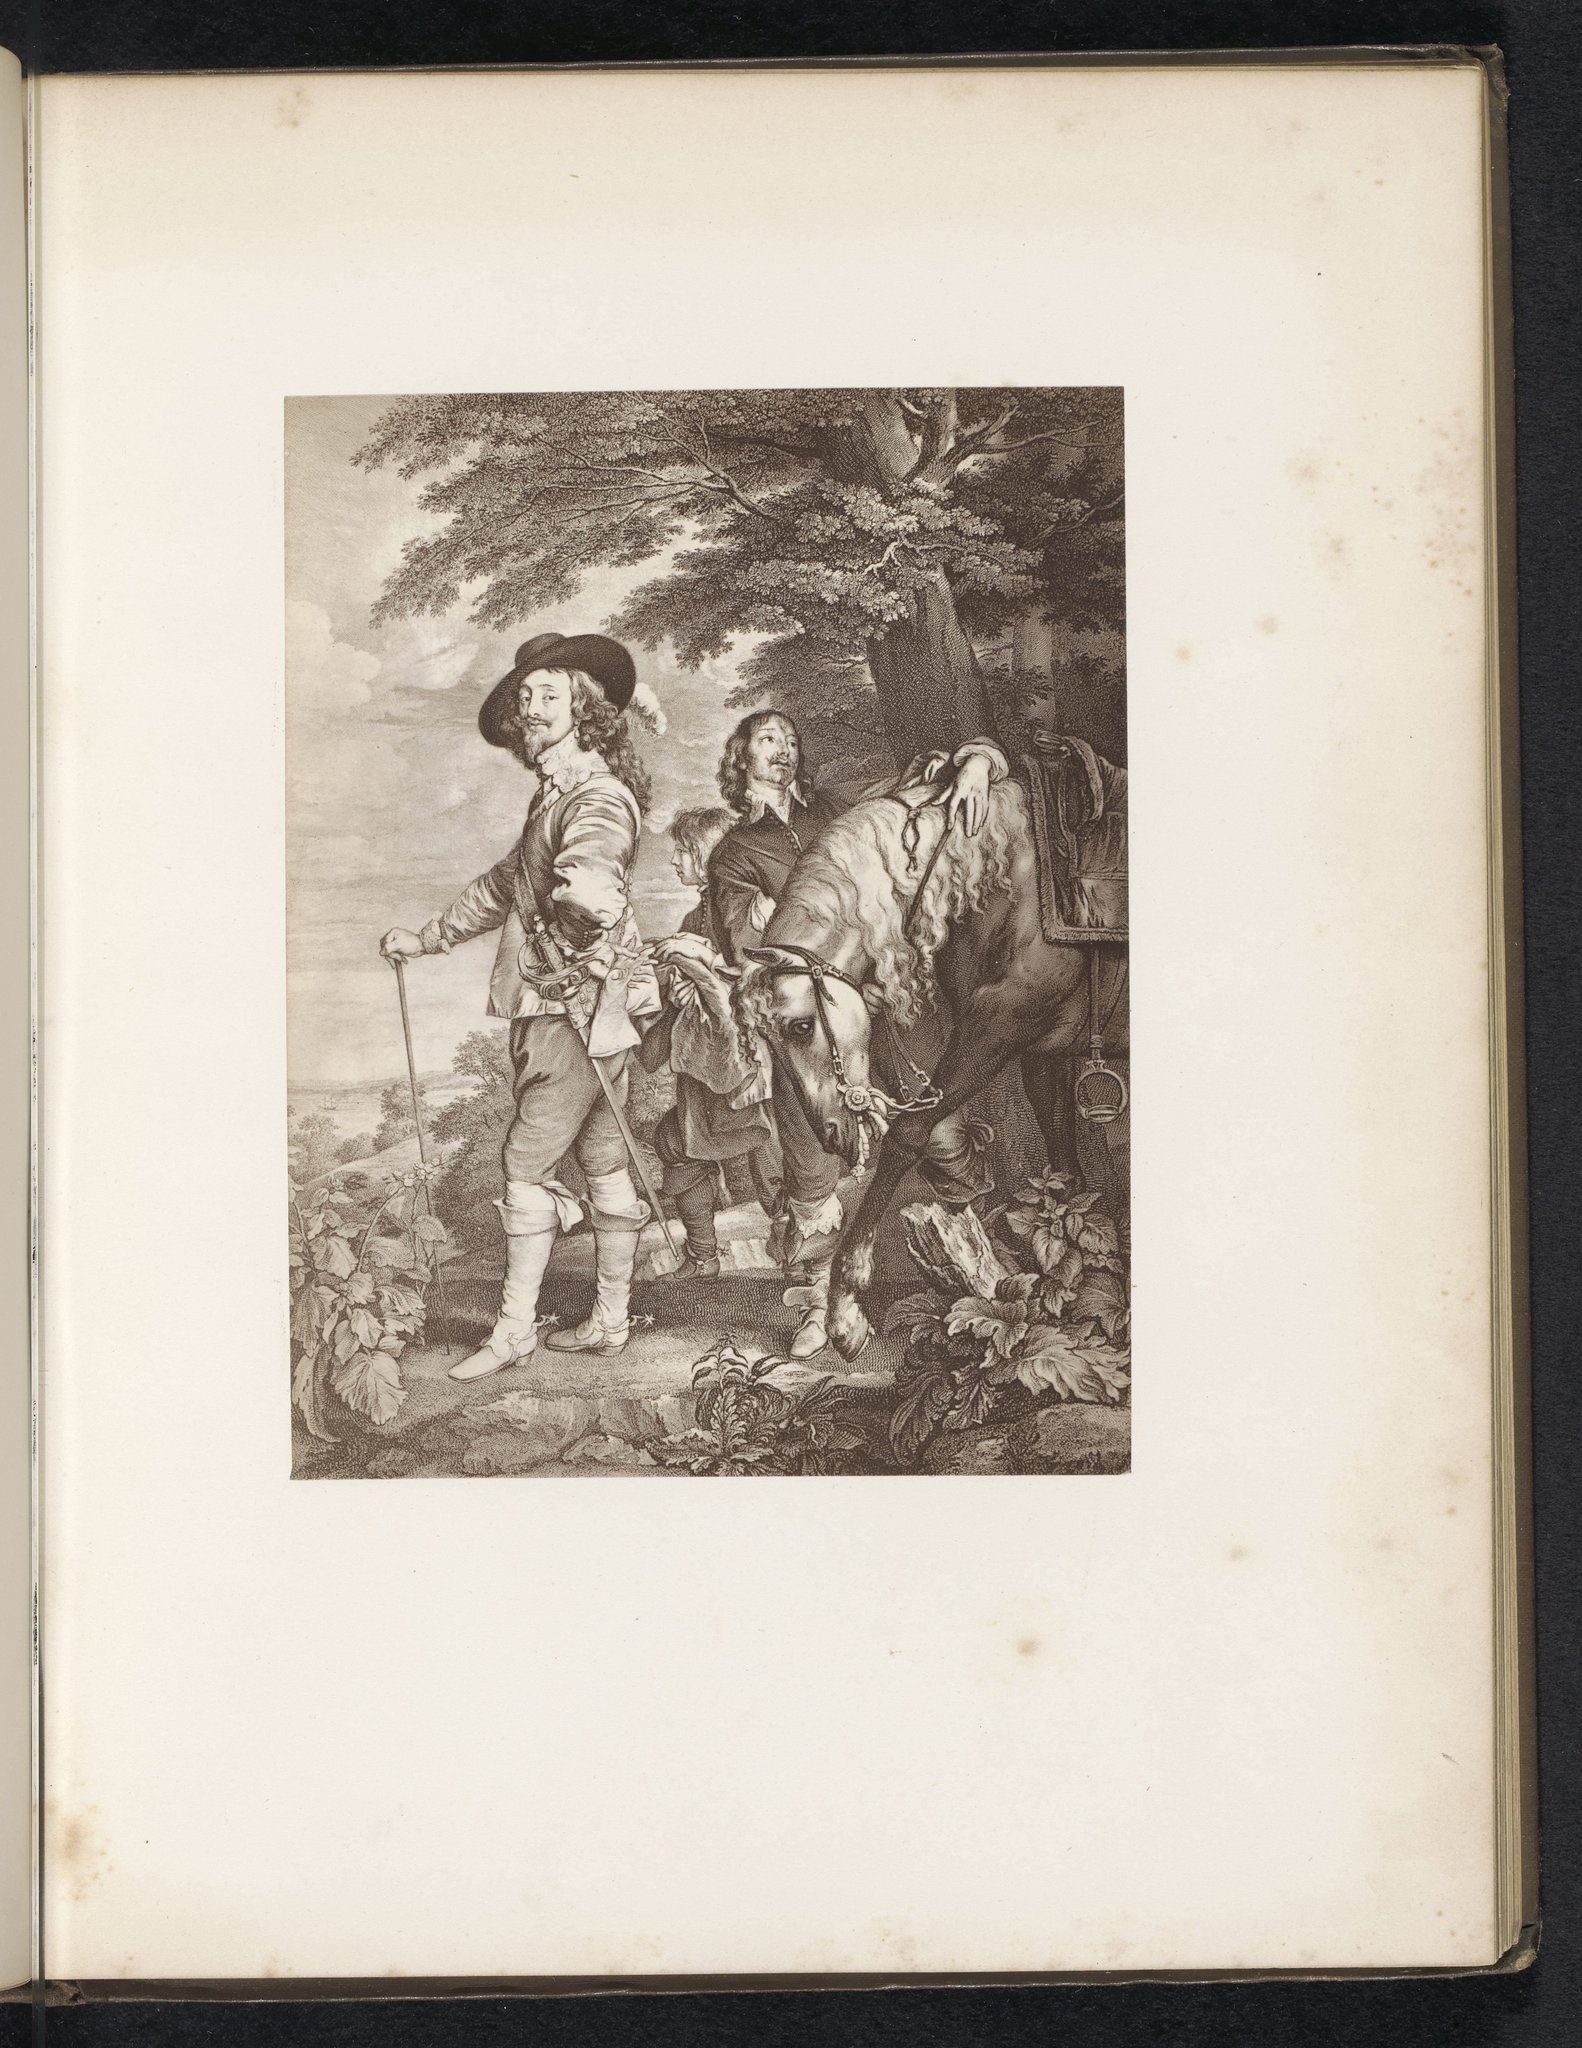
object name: photograph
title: Fotoreproductie van een prent naar het schilderij Le Roi à la chasse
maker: Anonymous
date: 1859-1869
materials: photographic support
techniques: albumen print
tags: hunting, chase, ruler, sovereign, horse